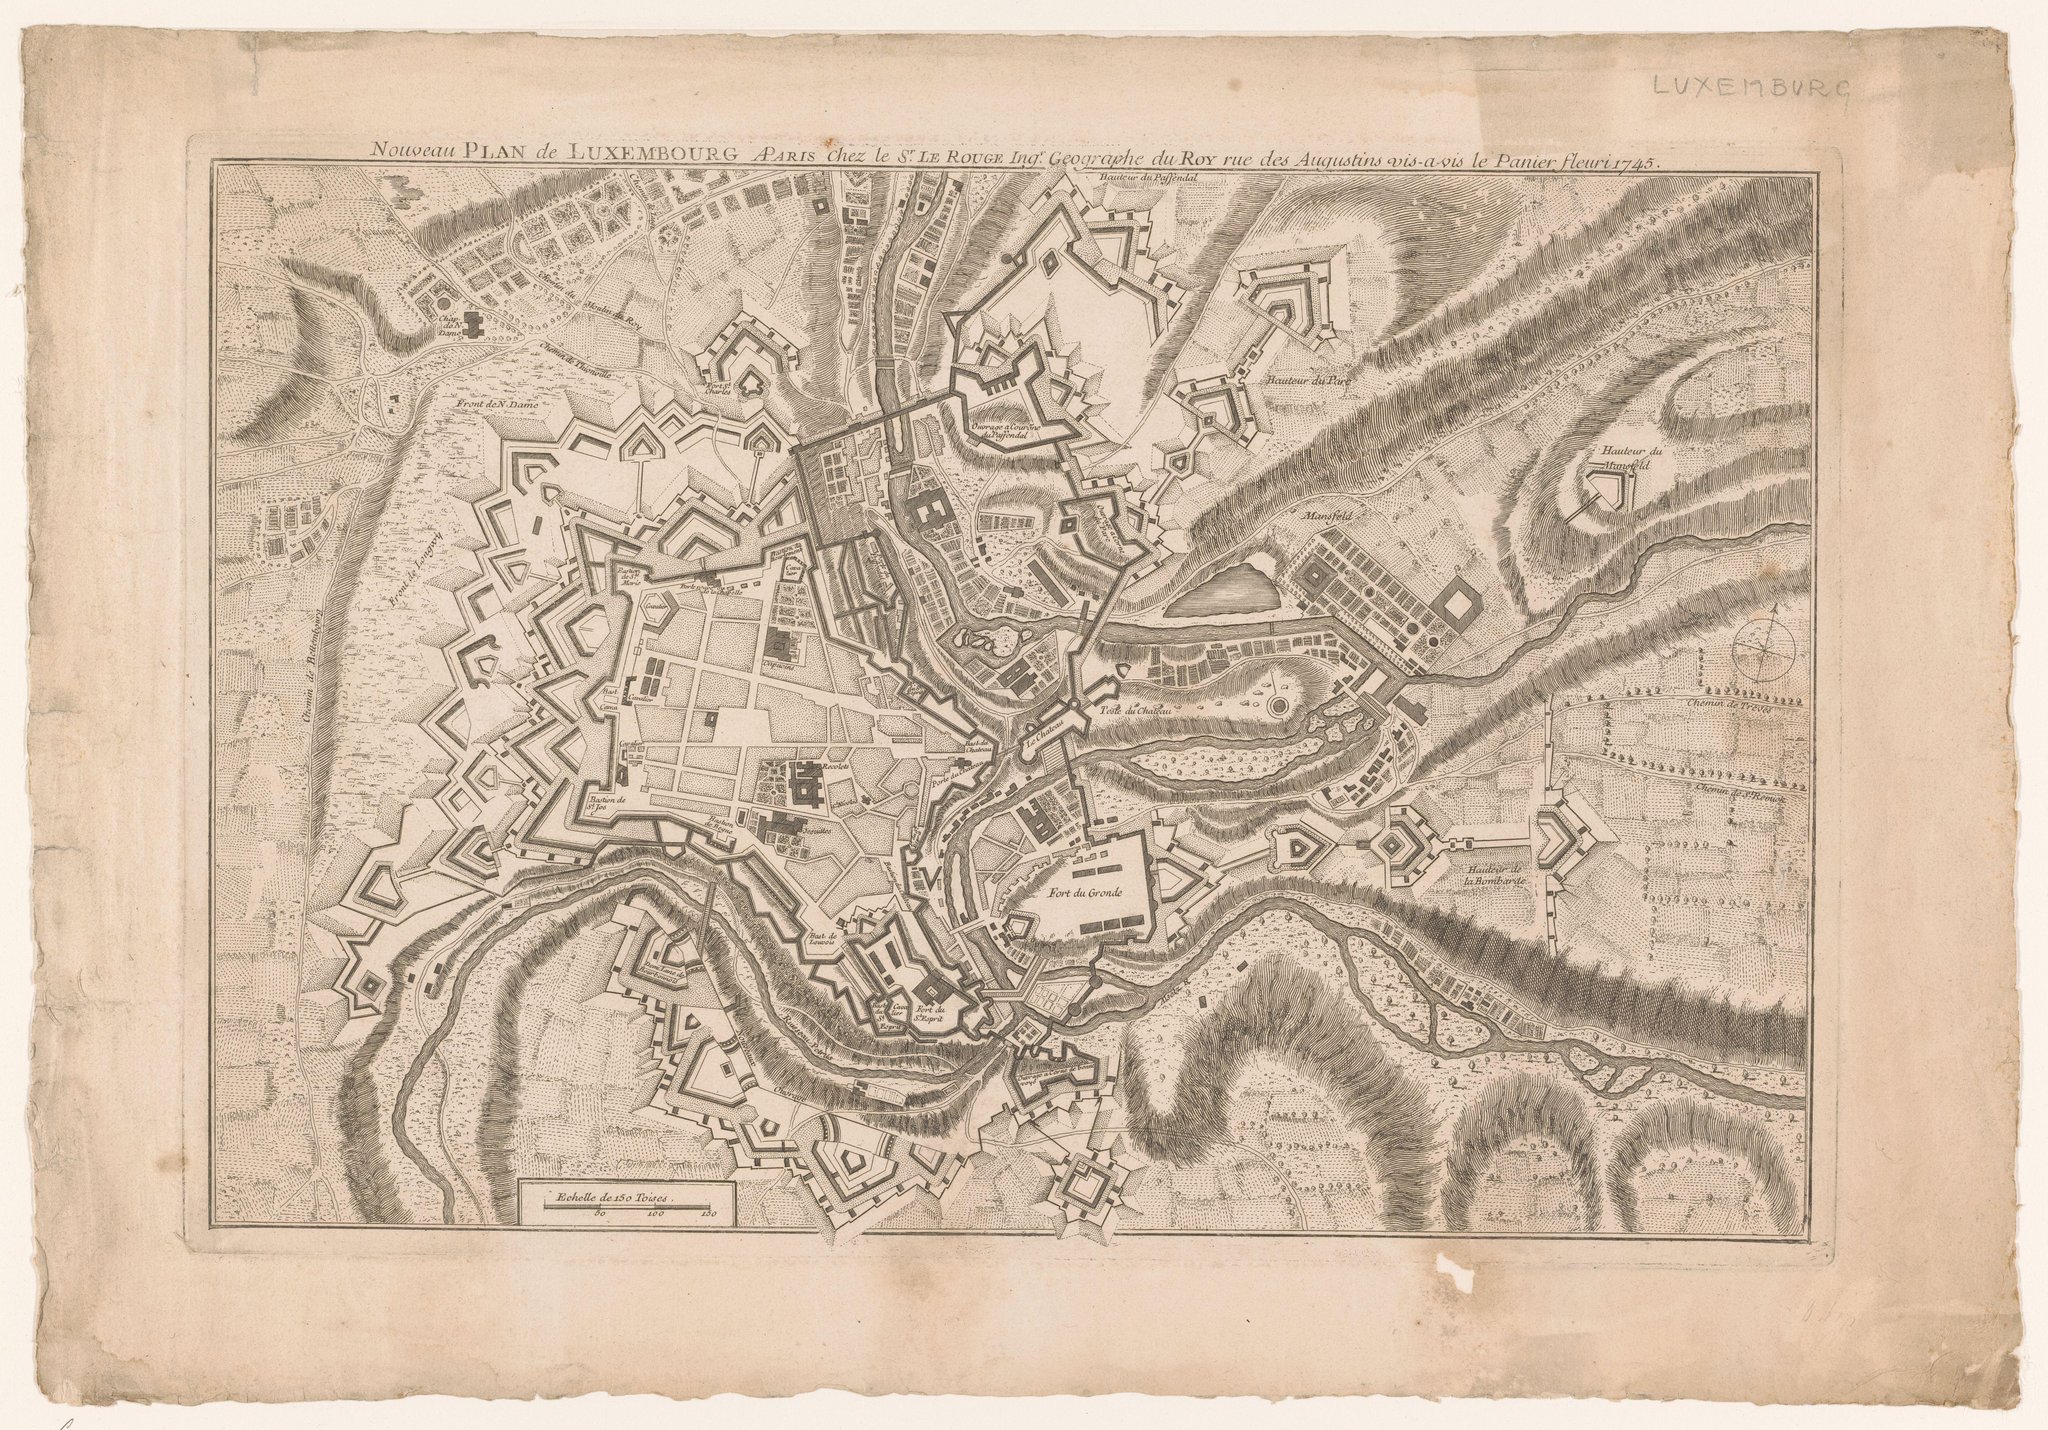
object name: print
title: Nouveau plan de Luxembourg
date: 1745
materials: paper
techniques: engraving, etching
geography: paris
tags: maps of cities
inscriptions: date